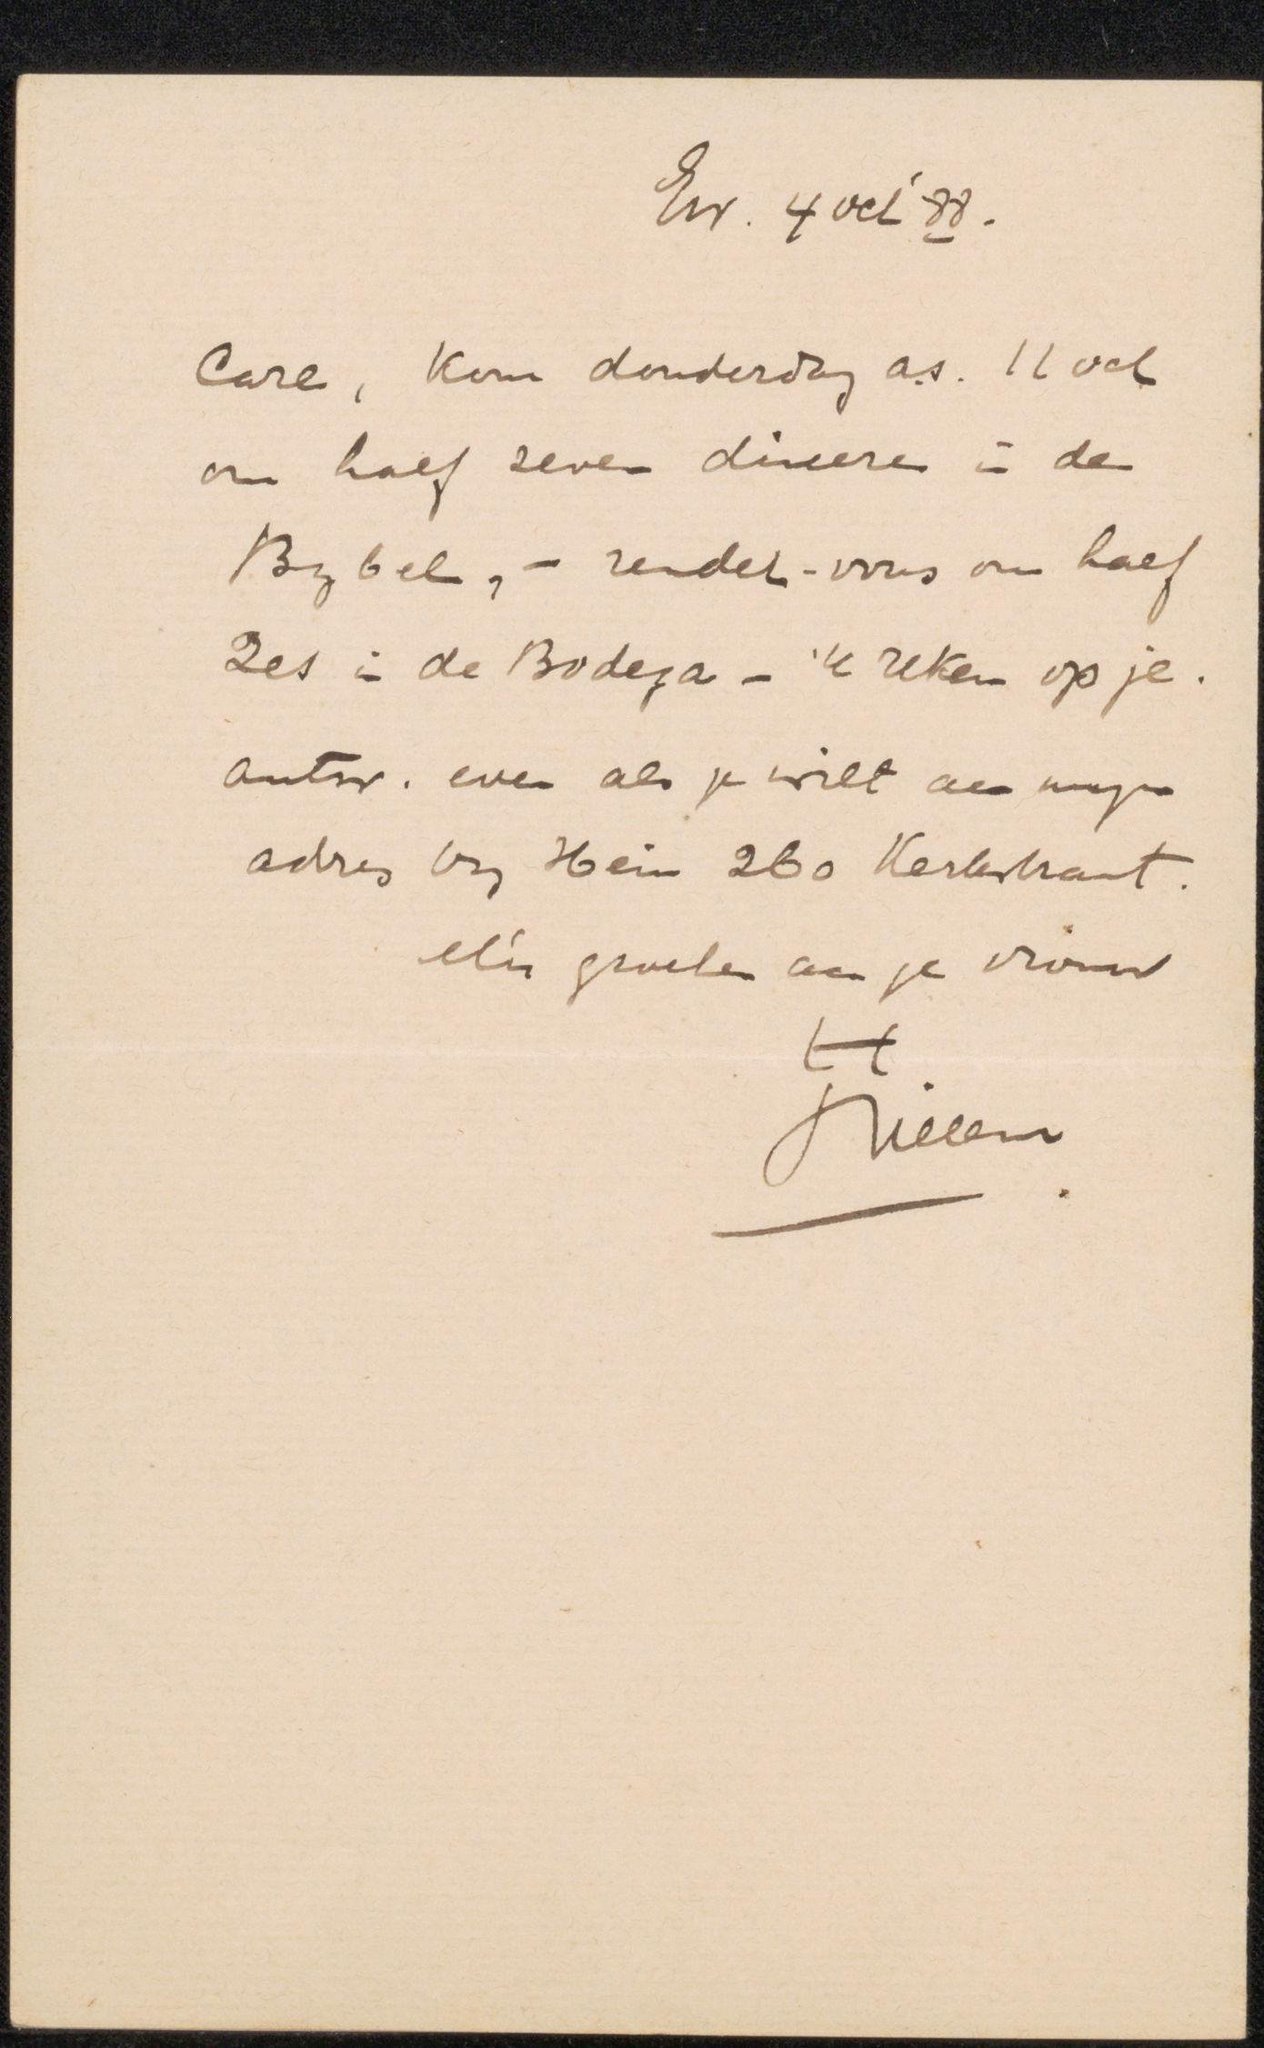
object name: letter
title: Brief aan Jan Veth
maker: willem witsen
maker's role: draughtsman, painter, print maker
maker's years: 1860-1923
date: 1888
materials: ink, paper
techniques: pen, writing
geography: ewijkshoeve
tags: designer, jan veth, amsterdam, hein boeken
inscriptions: watermark, collector's mark: ‘RPK’